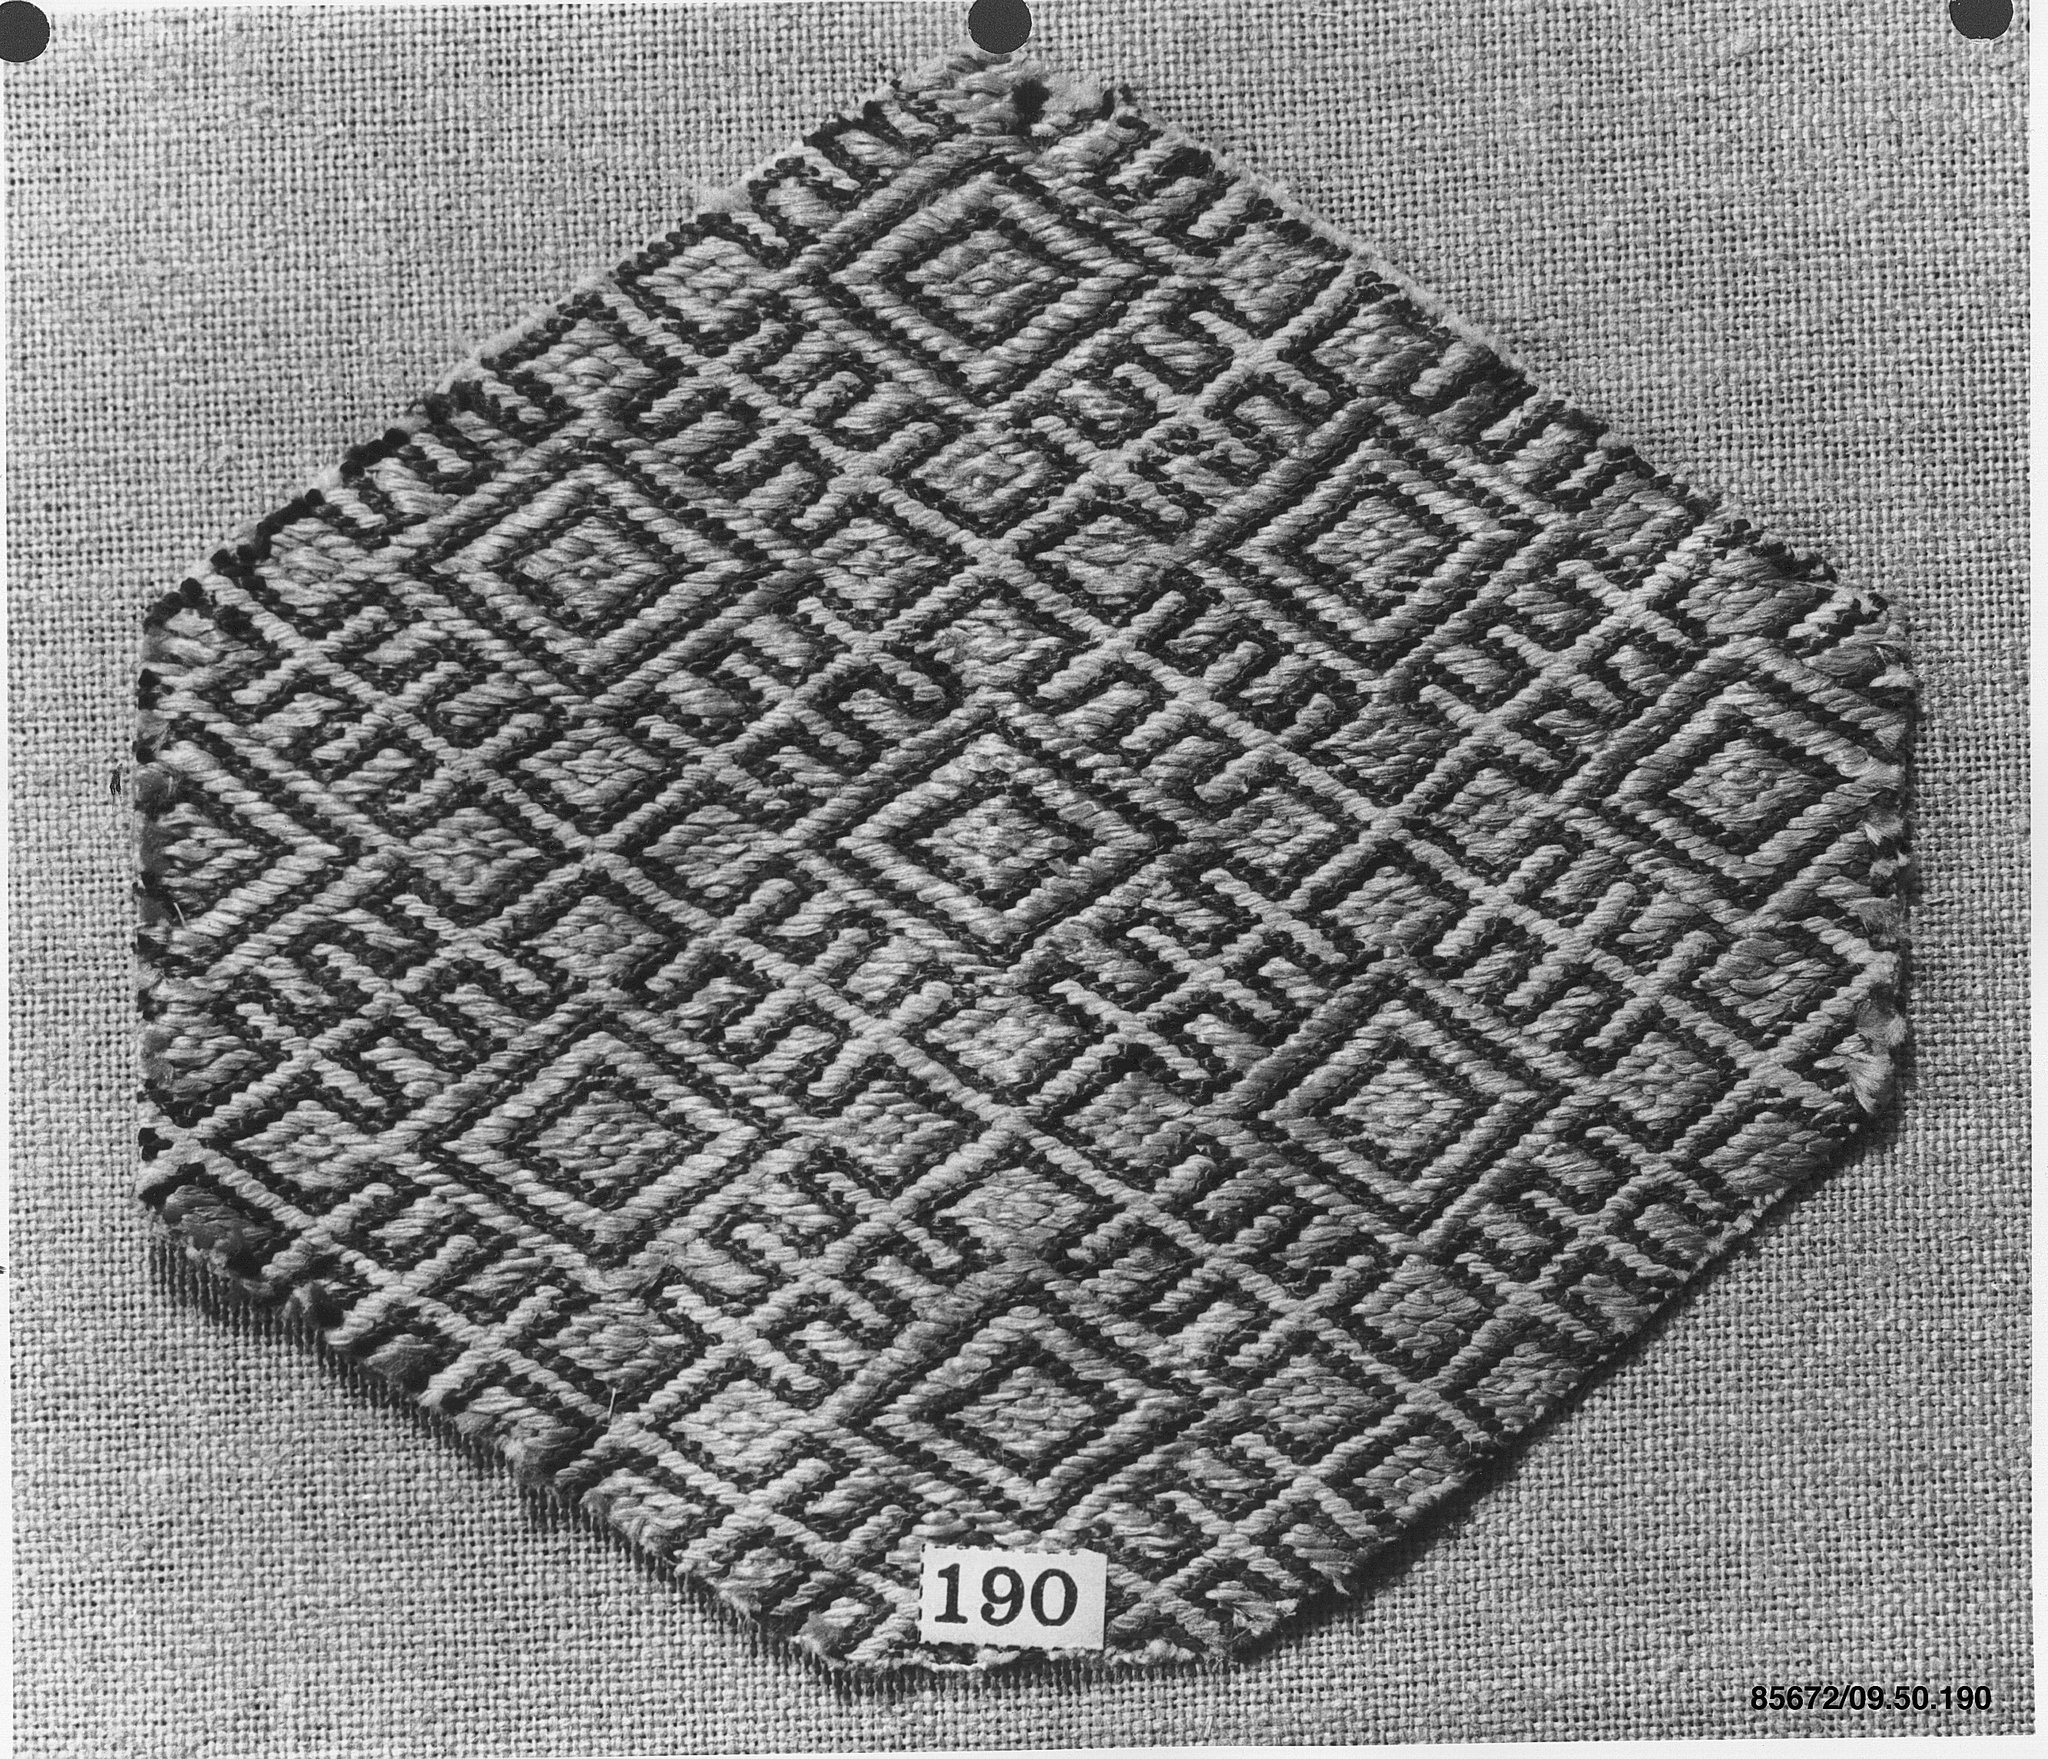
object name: costume fragment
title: Peasant costume fragment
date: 1701-1900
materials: canvas, silk